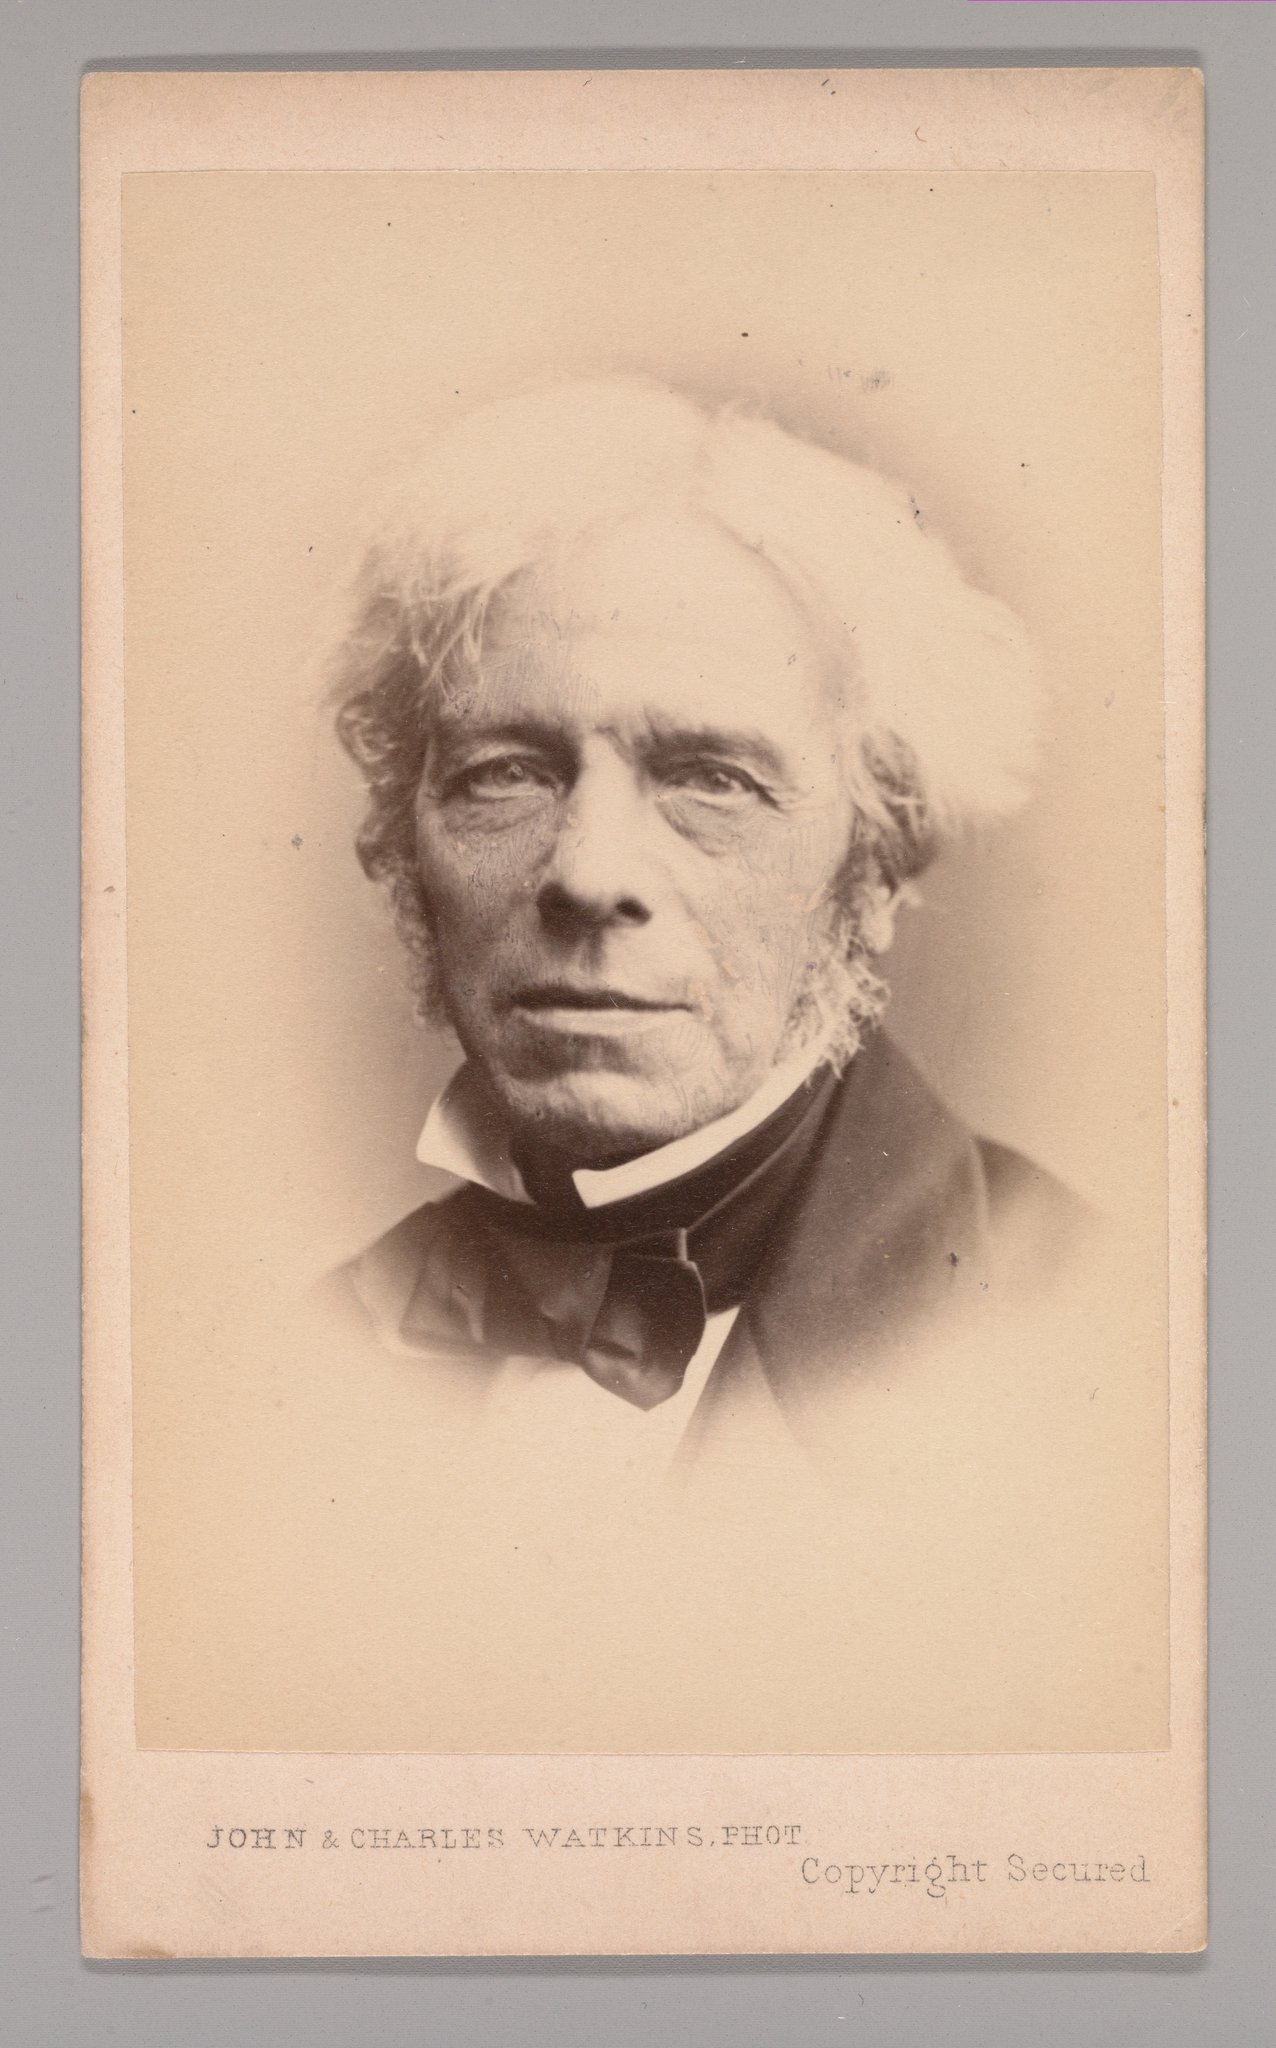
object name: carte de visite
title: [Unknown Subject]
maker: john and charles watkins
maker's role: photography studio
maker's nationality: british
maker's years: 1840-1875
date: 1860-1869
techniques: albumen silver print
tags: men,portraits